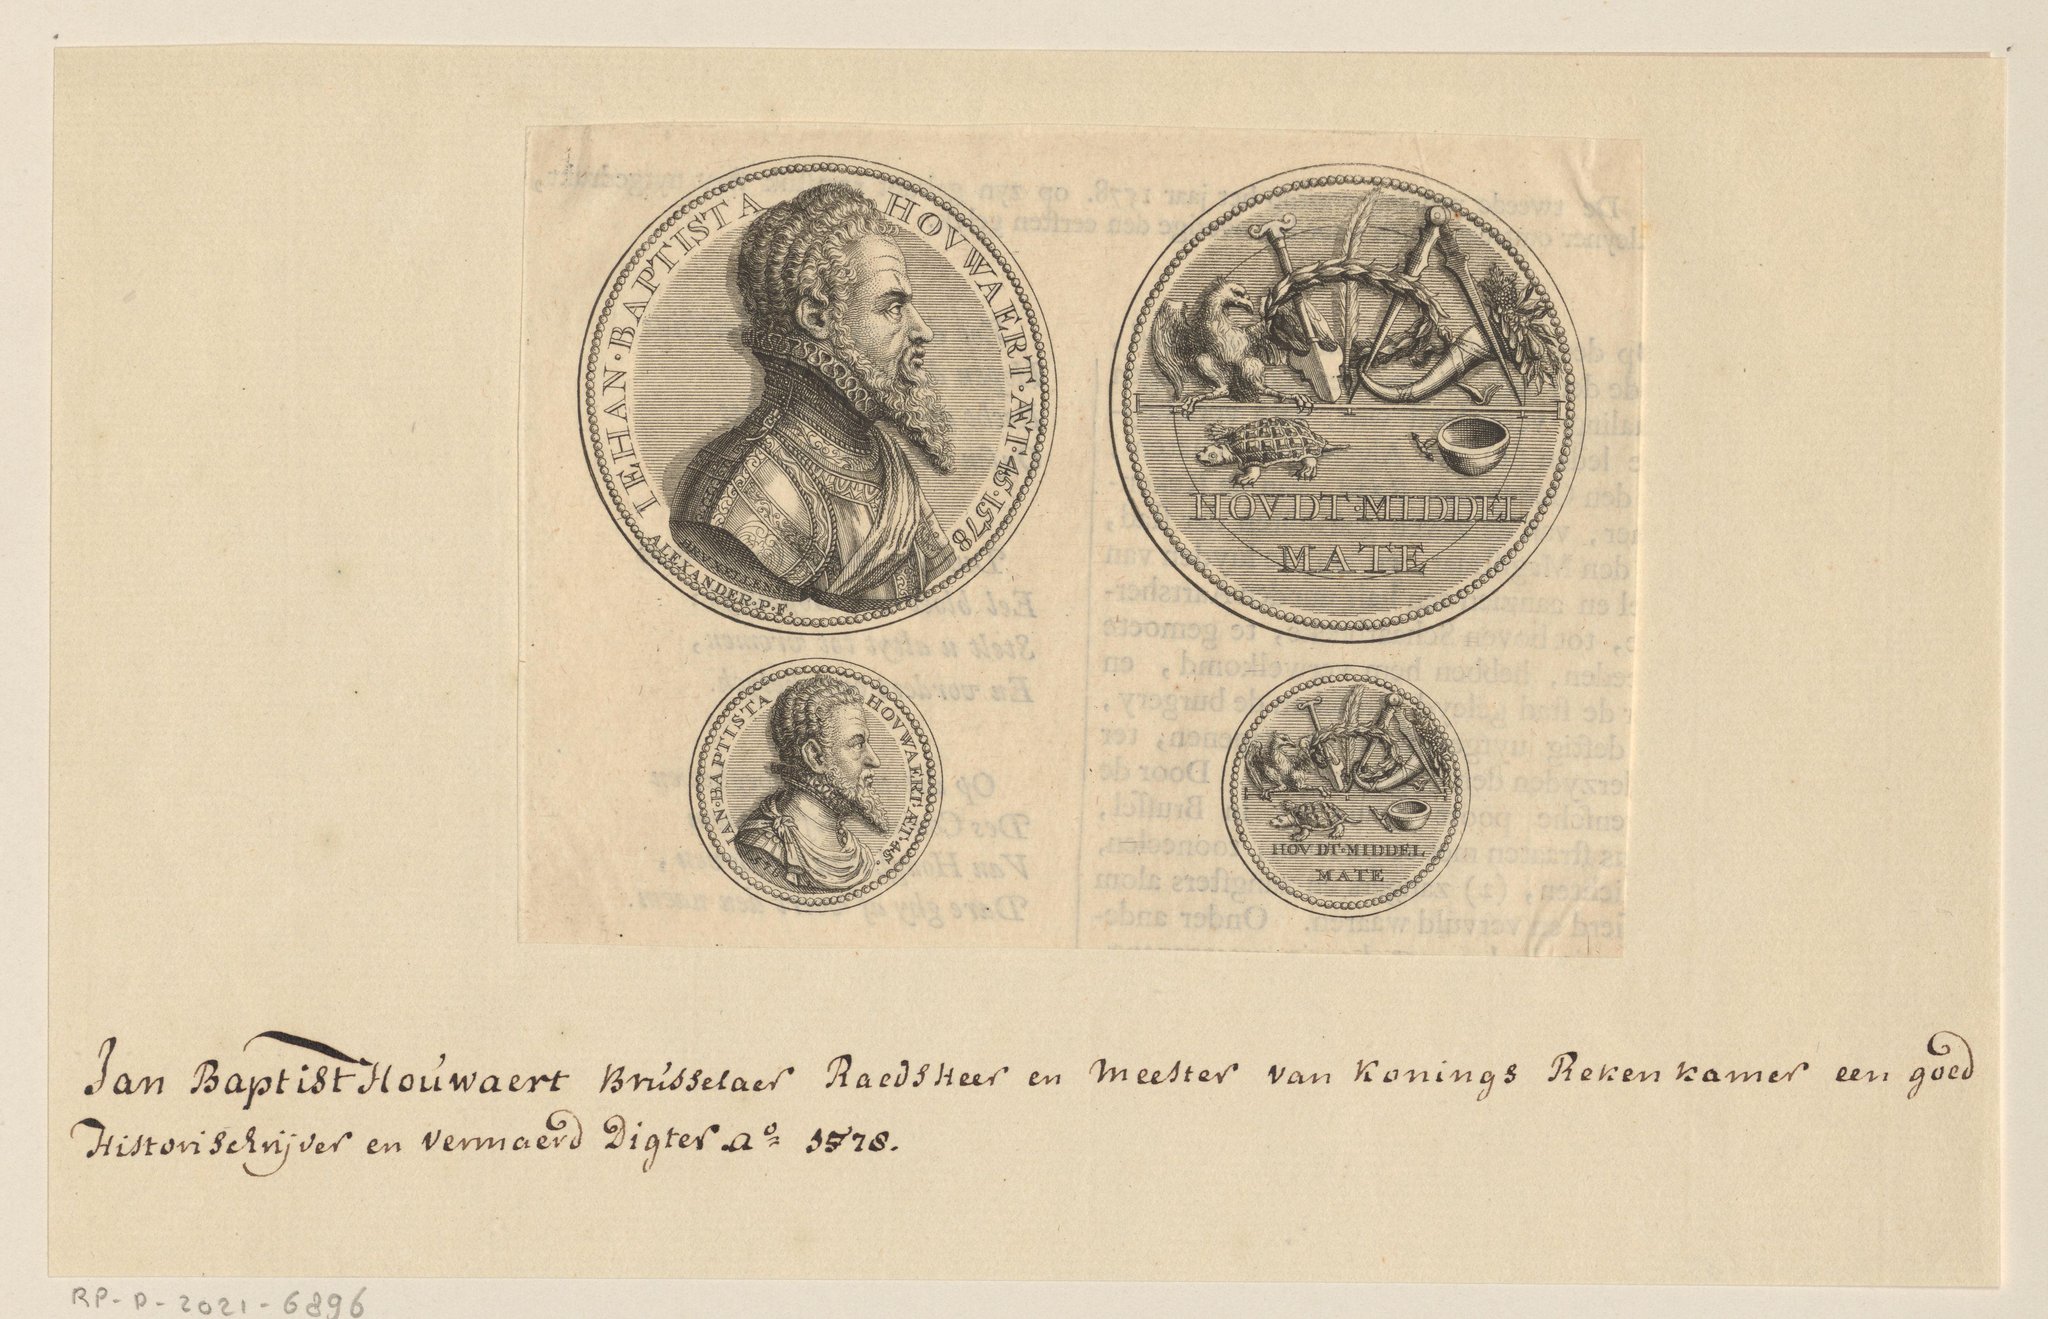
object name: print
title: Penningen met portret van Jan Baptist Houwaert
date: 1723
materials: paper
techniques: etching, letterpress printing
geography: the hague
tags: historical persons, medal (considered as a piece of sculpture, regardless of its specific function)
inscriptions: inscription: ‘Jan Baptist Houwaert Brusselaer Raedsheer en meester van Konings Rekenkamer een goed/ historieschrijver en vermaerd digter a[nn]o 1578.’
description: Prent uit: Loon, Gerard van. Beschryving der Nederlandsche historipenningen (...). Den Haag: Christiaan van Lom, Isaac Vaillant, Pierre Gosse, Rutgert Christoffel Alberts en Pieter de Hondt, 1723, dl. 1, p. 245.